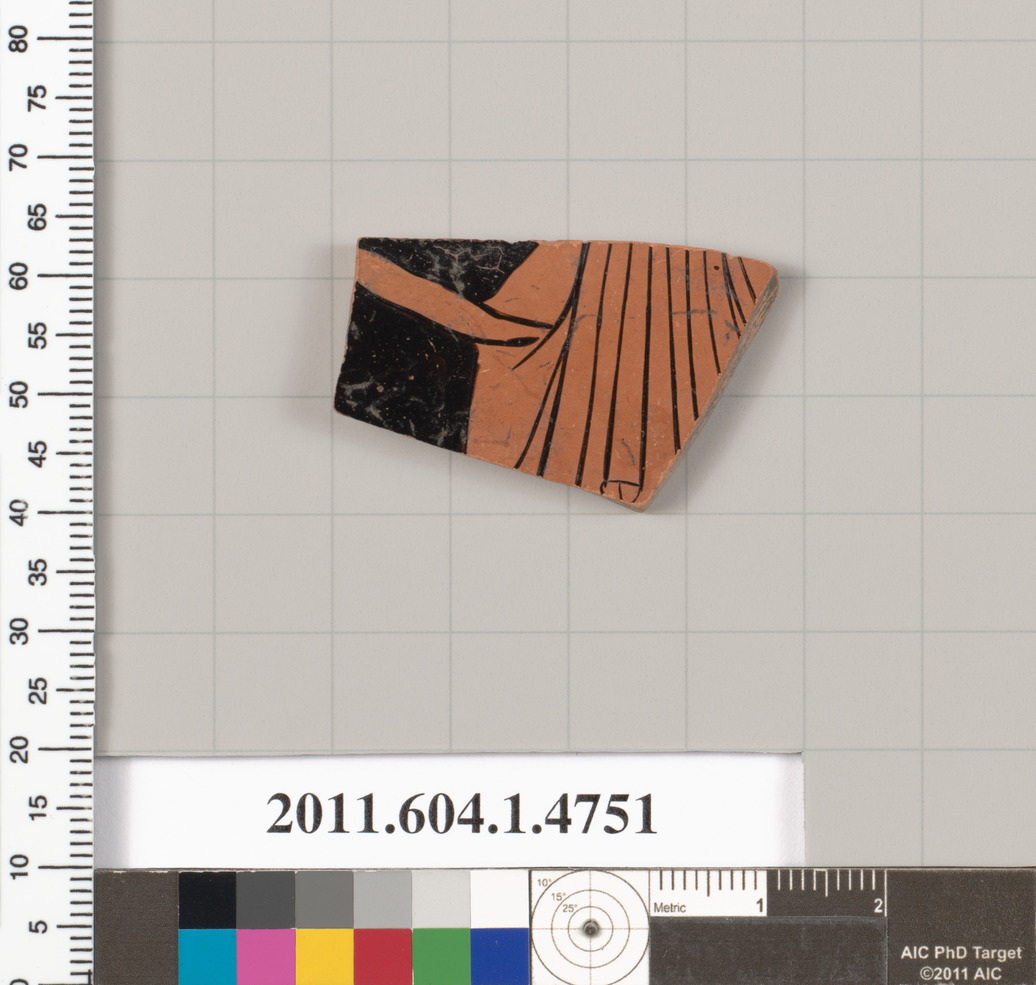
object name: kylix fragment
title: Terracotta fragment of a kylix (drinking cup)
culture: greek, attic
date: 490-480 BCE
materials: terracotta